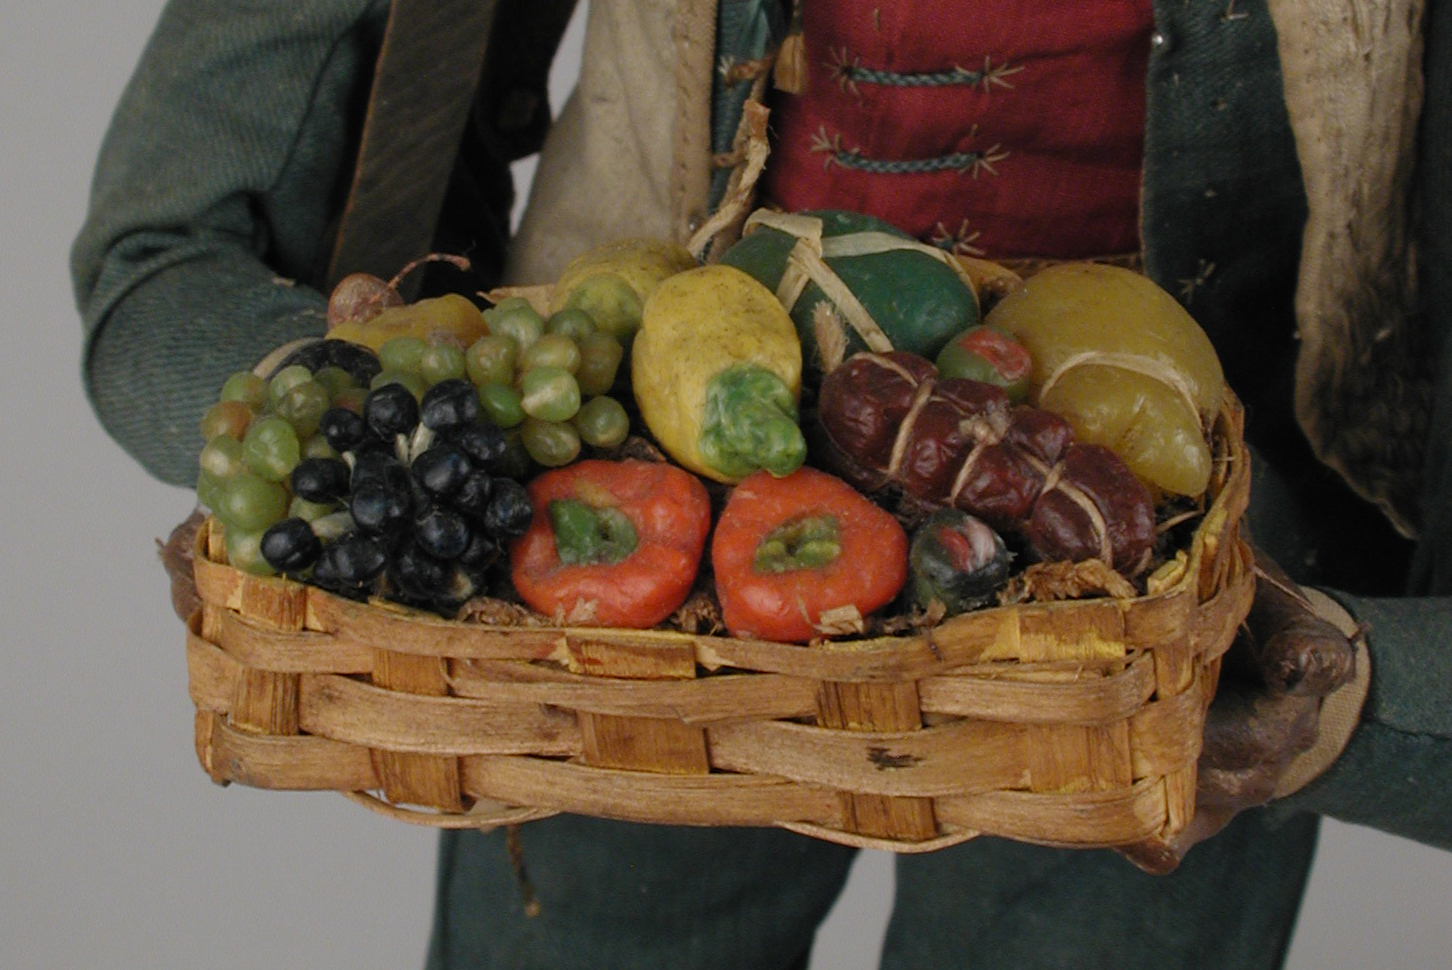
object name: crèche accessory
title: Basket of food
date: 1701-1800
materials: wax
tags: grapes,vegetables